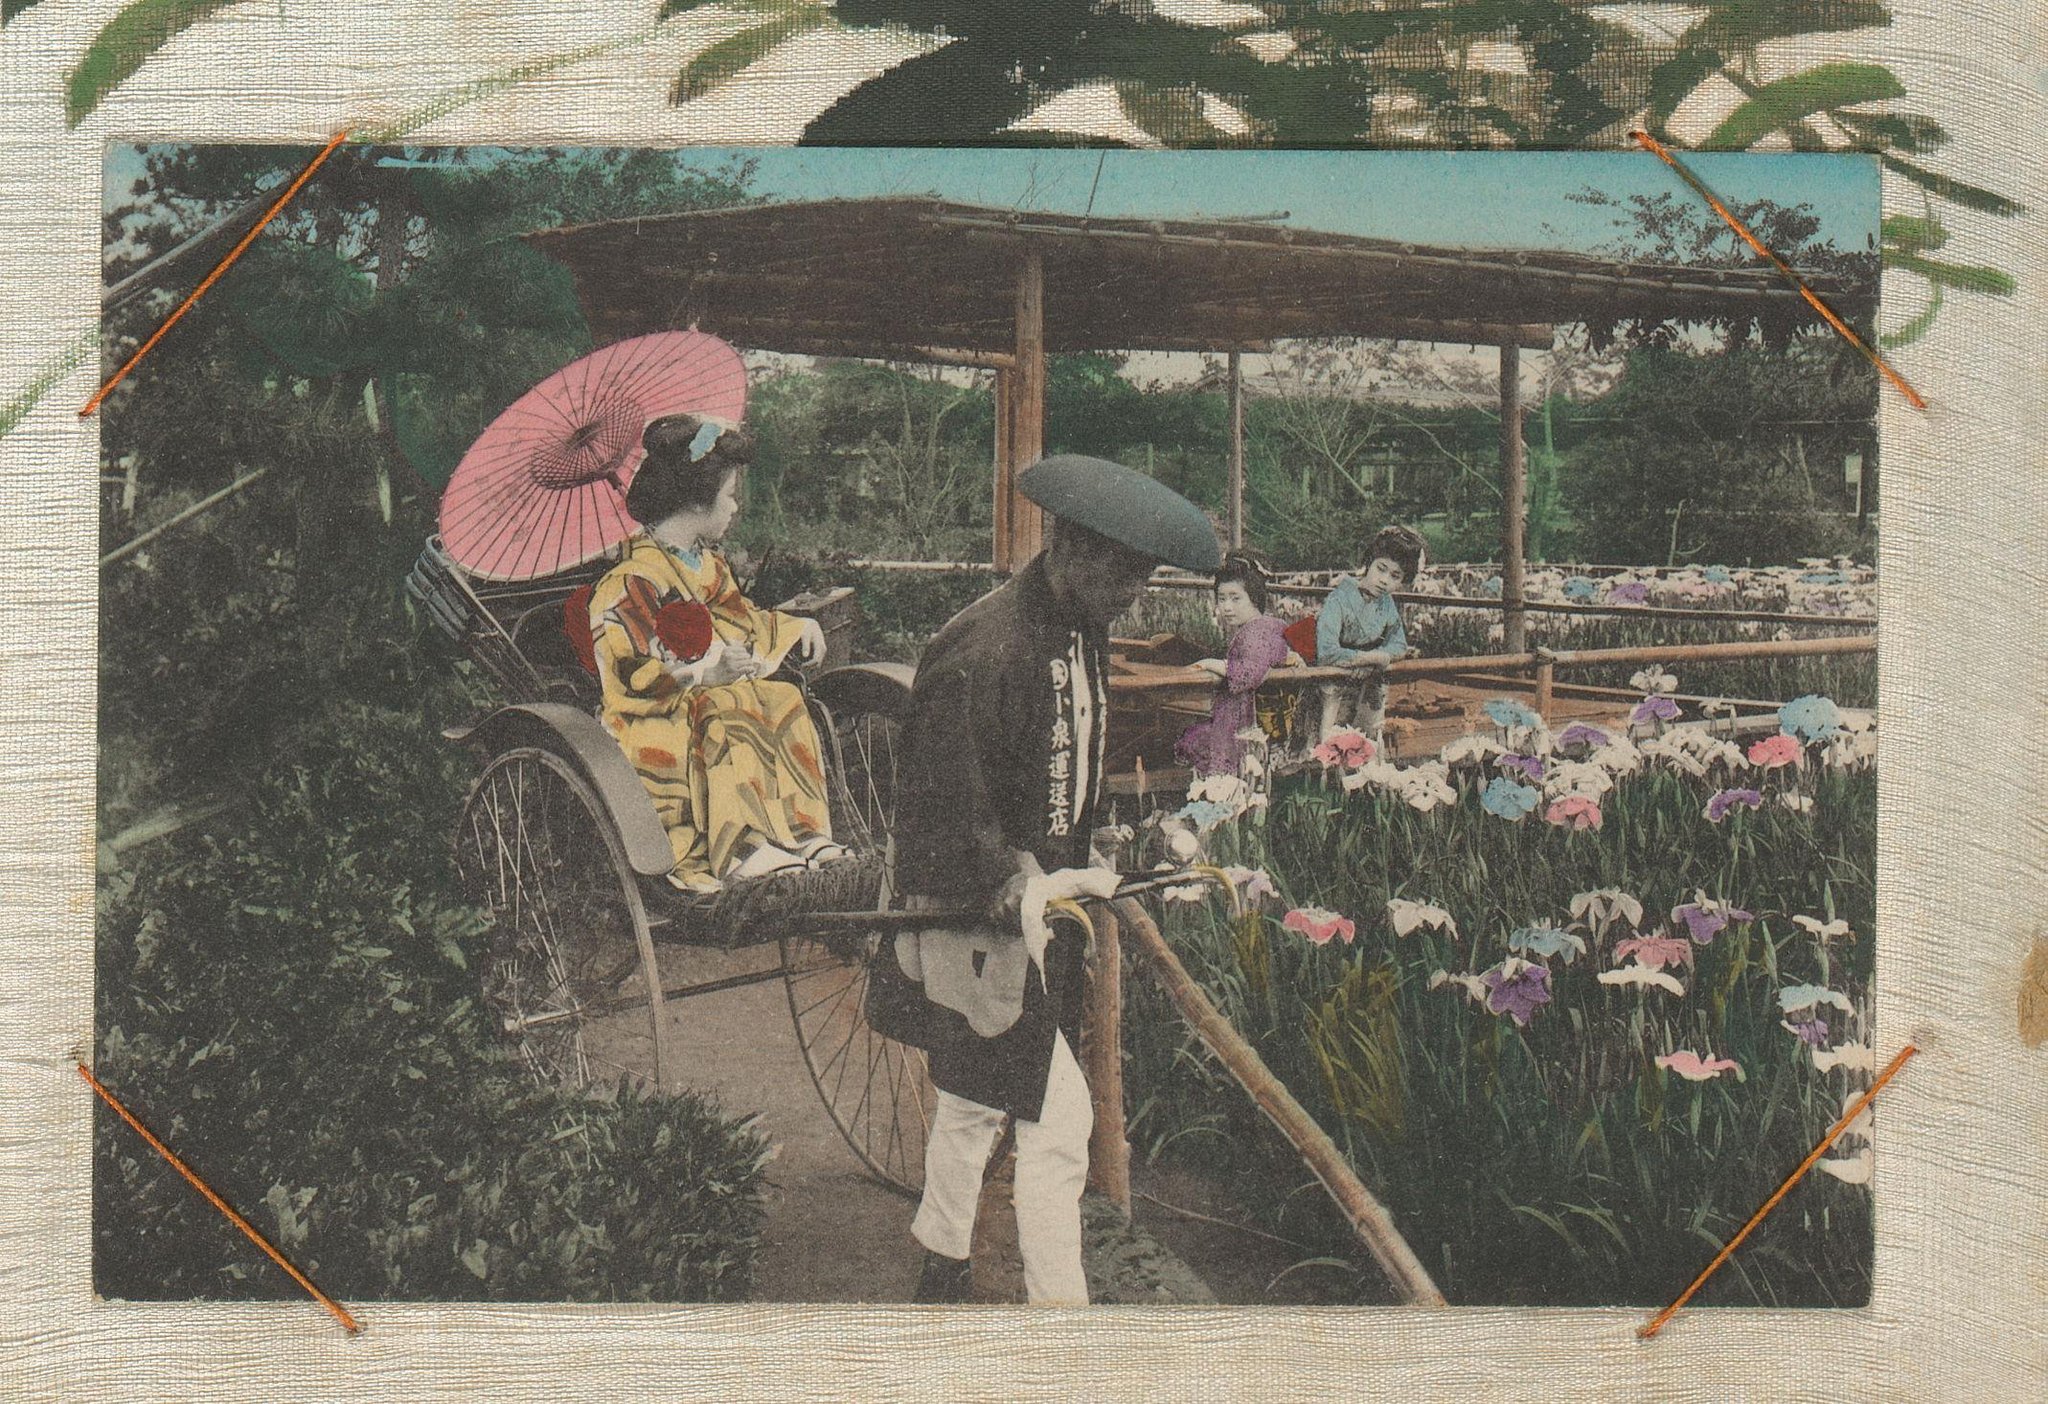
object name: photomechanical print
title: Japanse vrouw in kimono in een riksja, twee andere vrouwen op de achtergrond in een paviljoen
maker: Anonymous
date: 1900-1920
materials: paper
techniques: photograph, hand coloring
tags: rickshaw, historical persons, adult woman (+ three persons), folk costume, regional costume, parasol, sunshade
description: Deze prent maakt deel uit van een album.